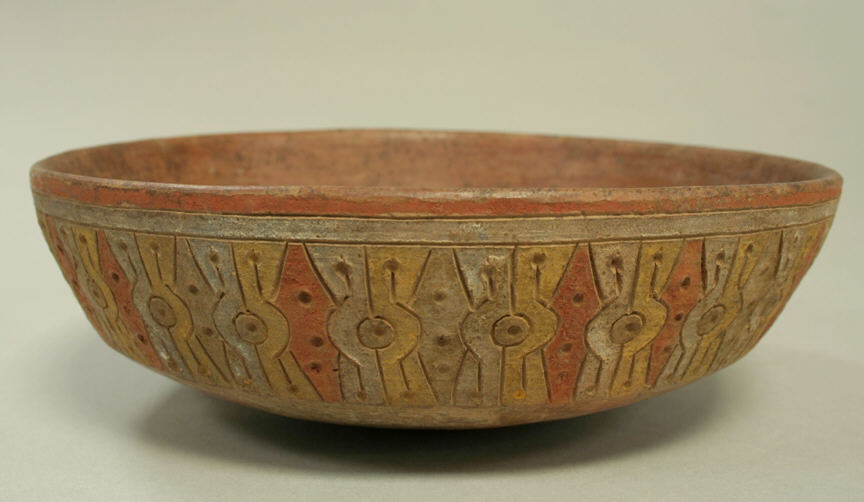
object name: bowl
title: Incised Painted Bowl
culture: paracas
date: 500-101 BCE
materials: ceramic, pigment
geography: peru